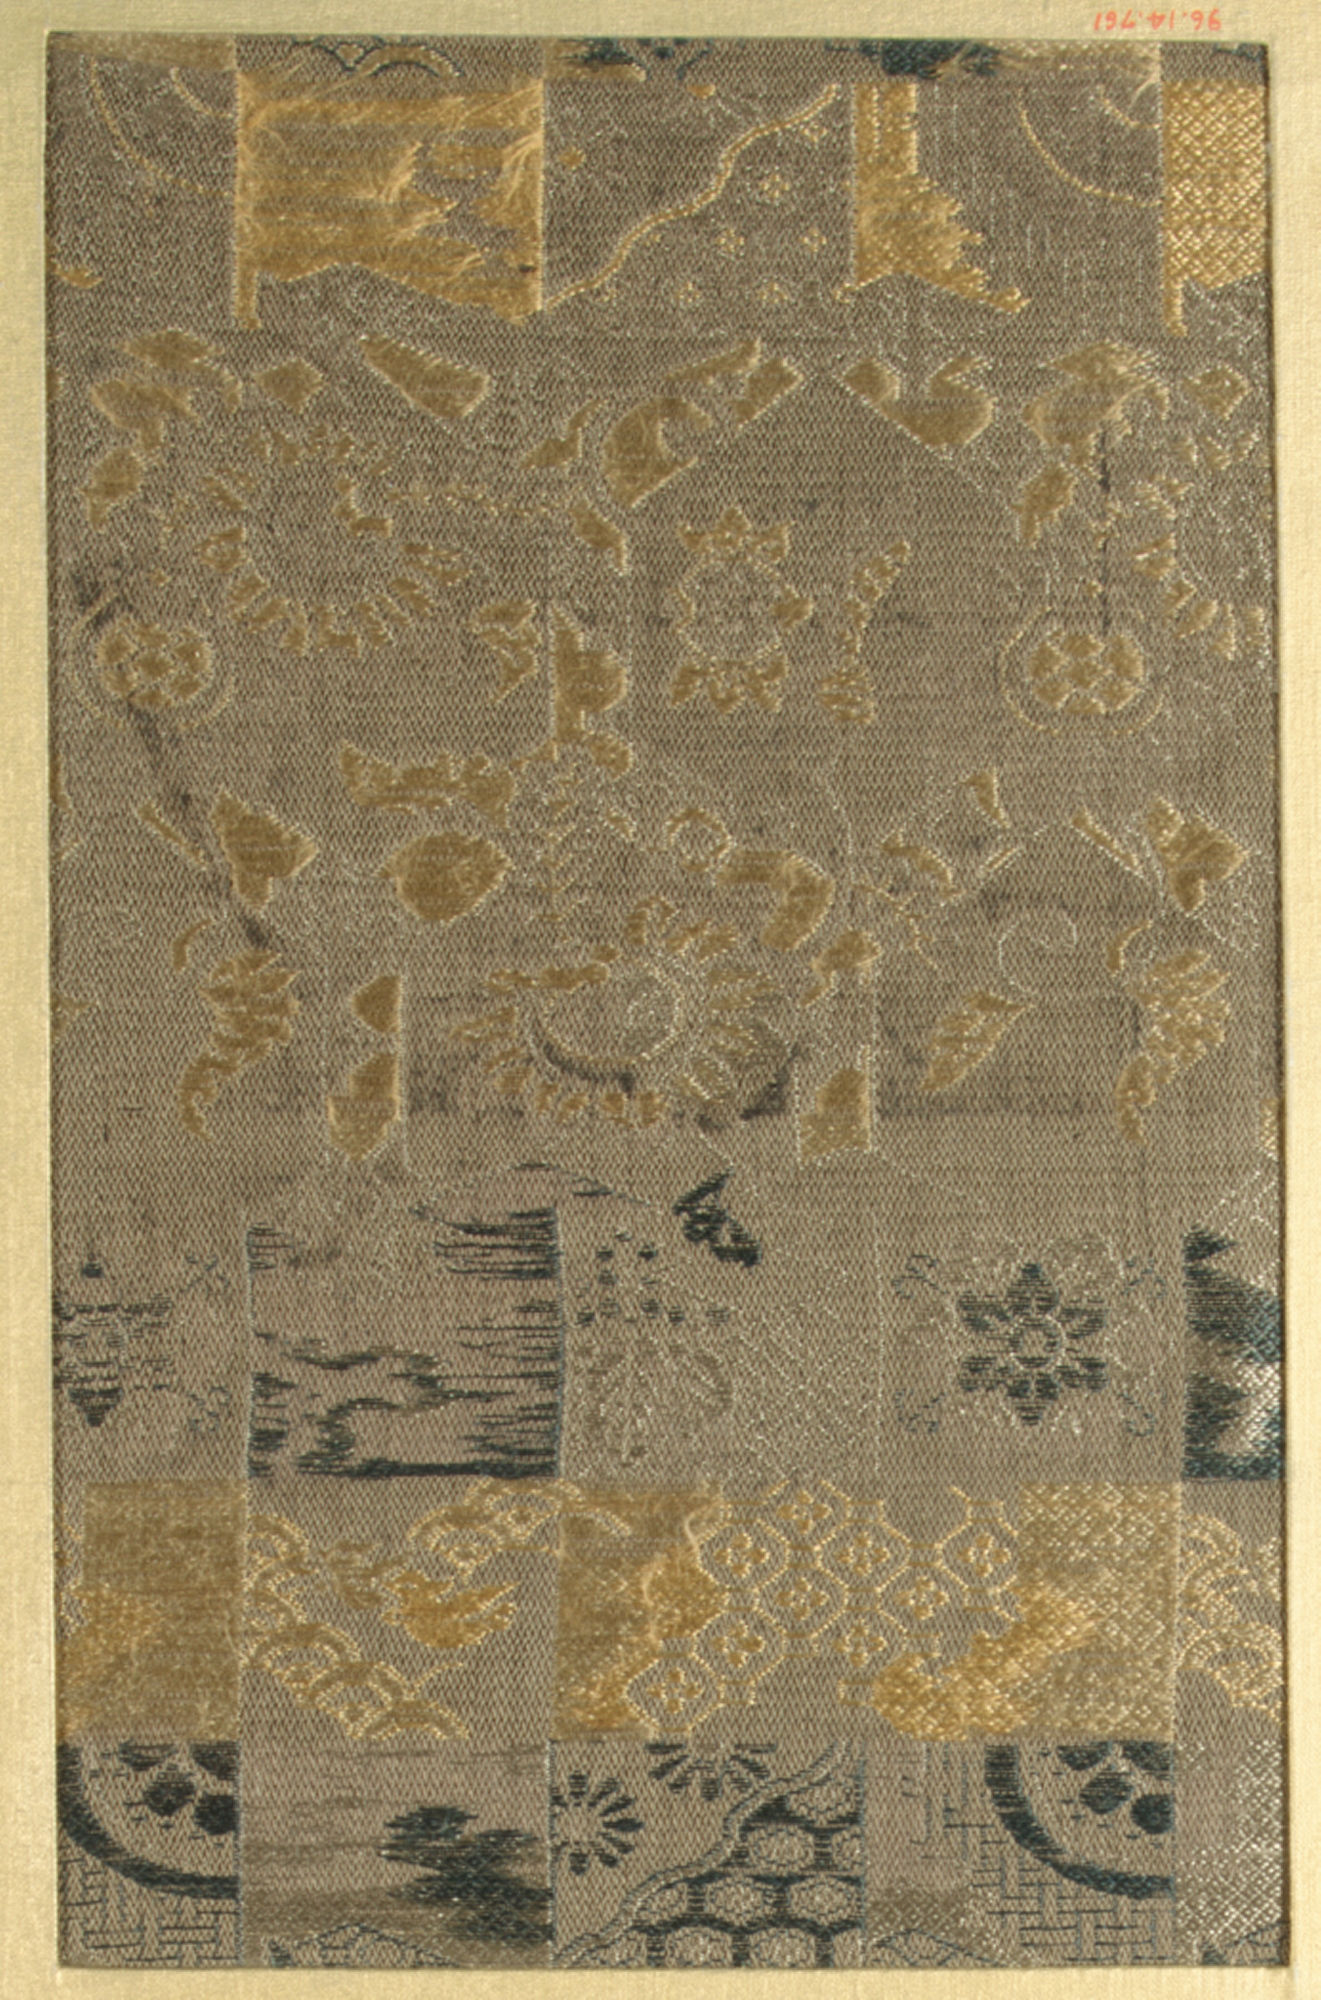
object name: piece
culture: japanese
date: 1701-1900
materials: silk